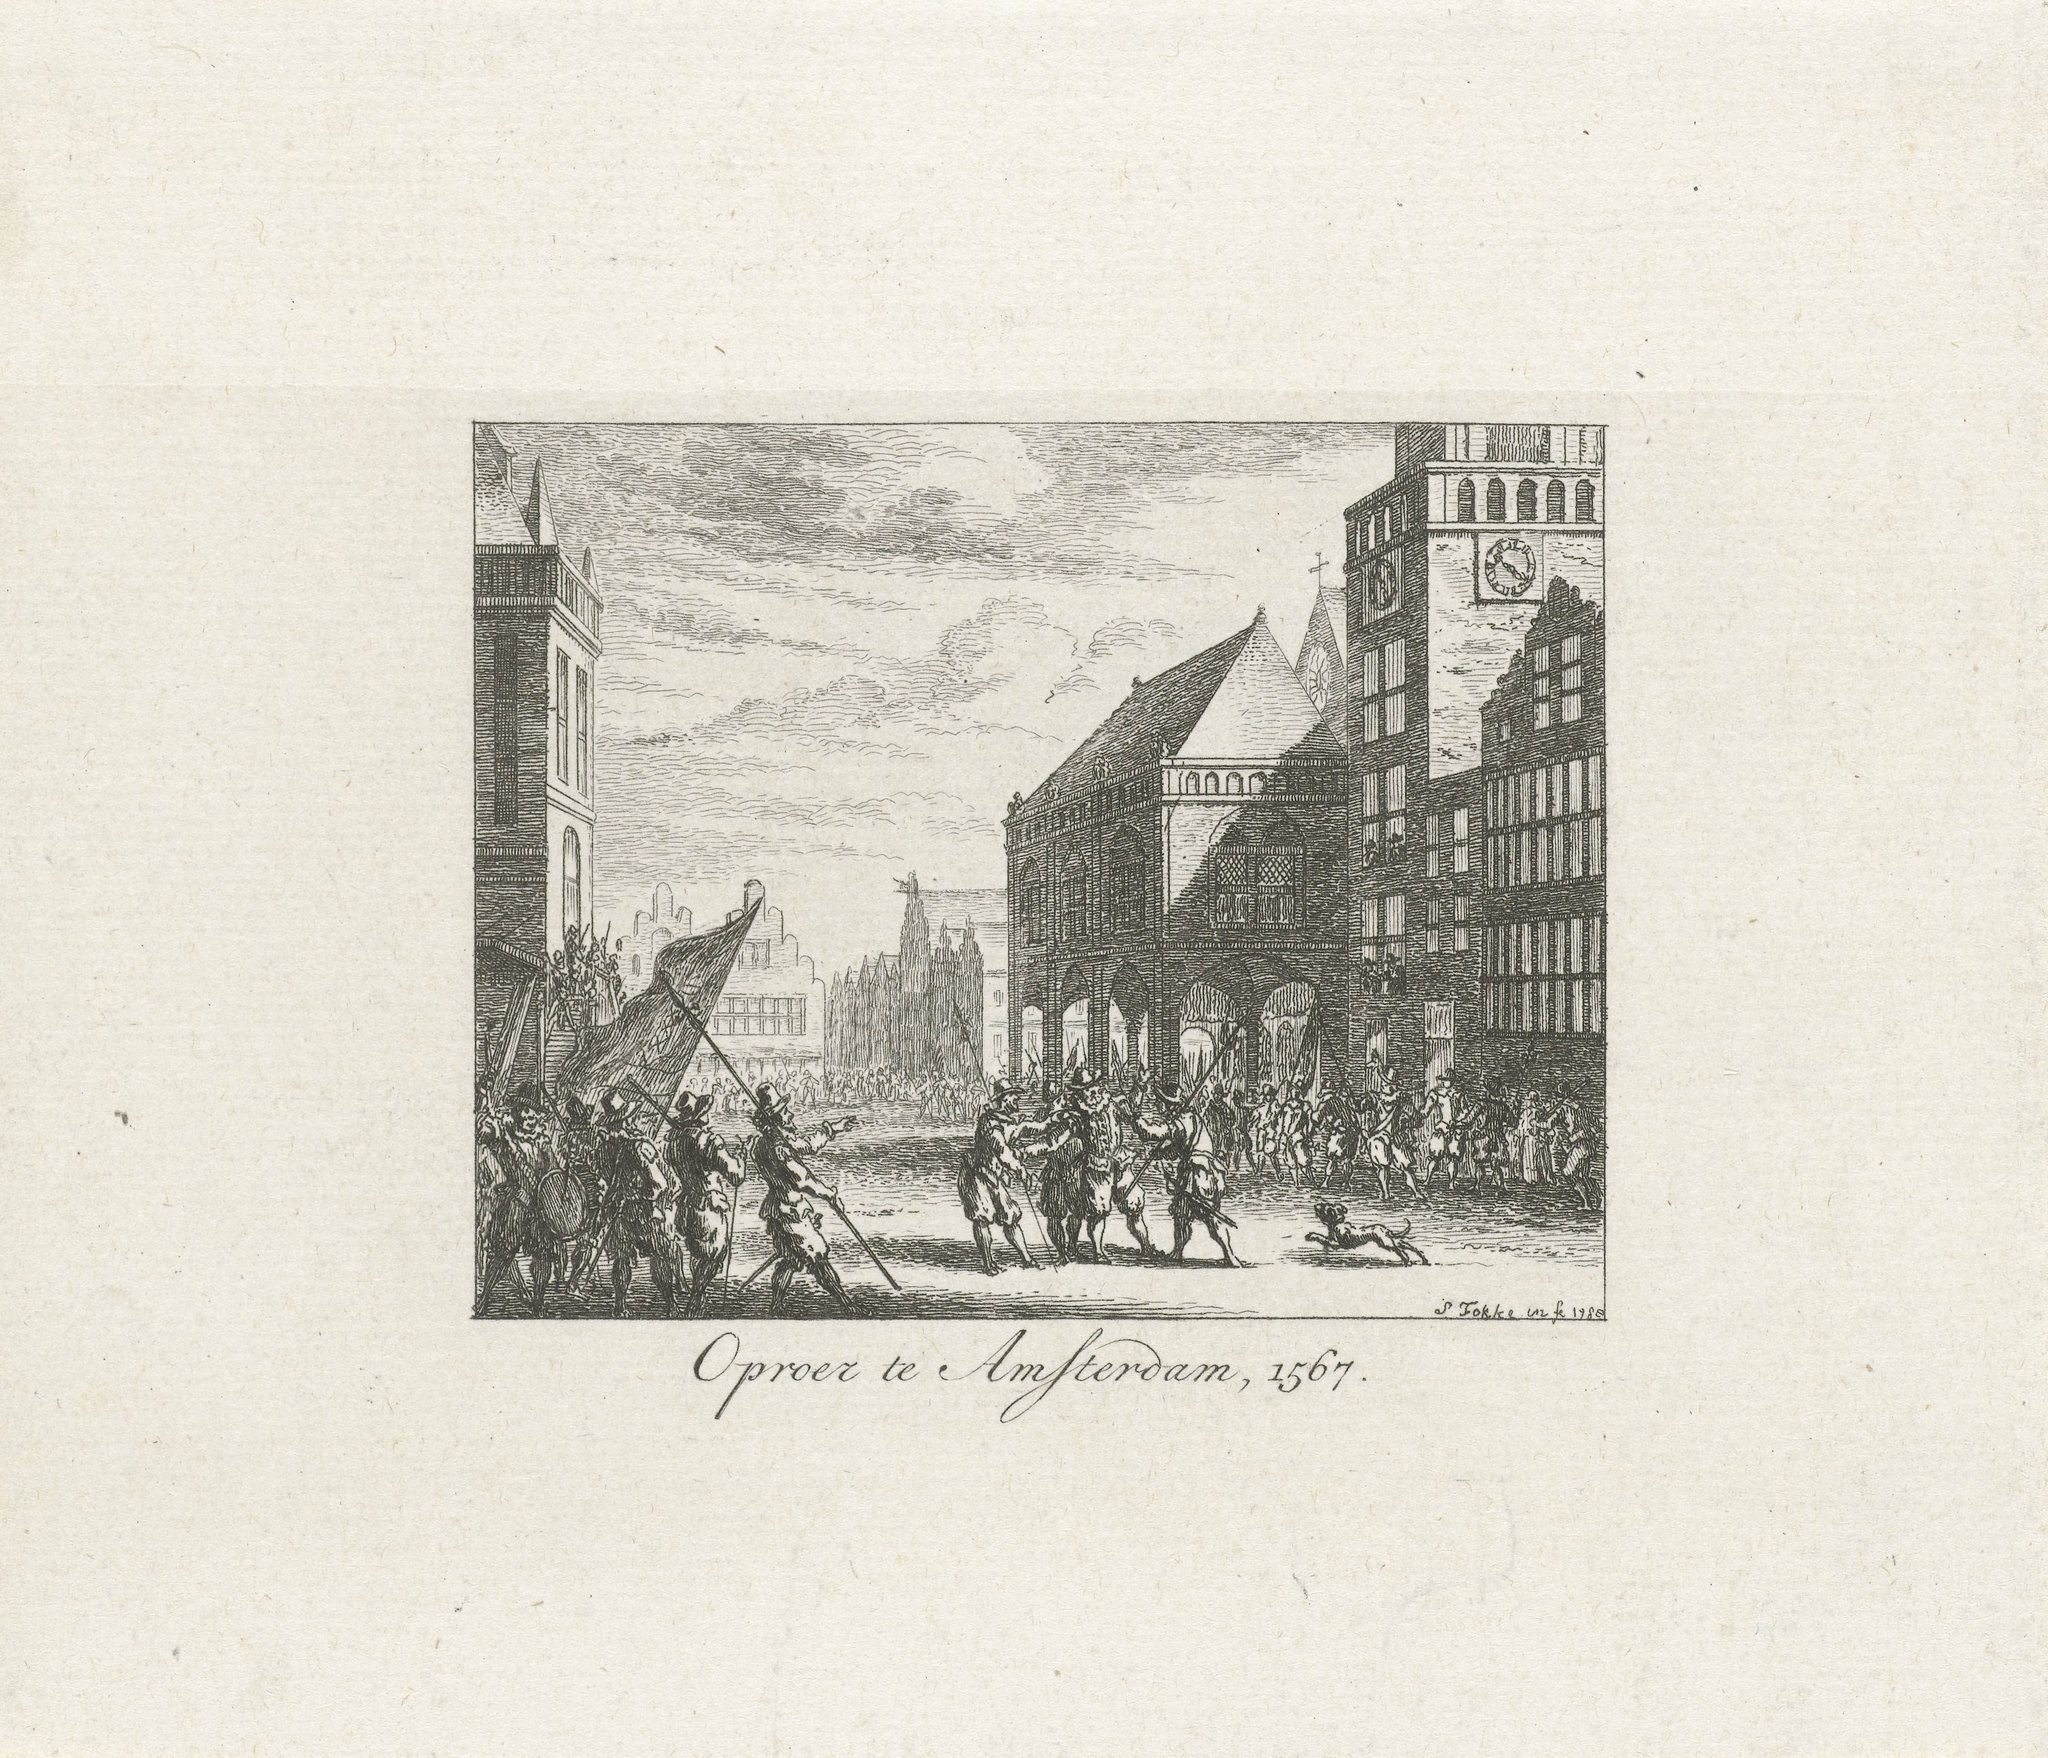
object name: history print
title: Oproer te Amsterdam, 1567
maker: simon fokke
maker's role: draughtsman, print maker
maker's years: 1712-1784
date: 1780-1784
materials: paper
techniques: etching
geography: northern netherlands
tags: street-fights, riots, amsterdam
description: Oproer te Amsterdam, 1567. Soldaten en burgers op de Dam voor het Oude Stadhuis, 1567.